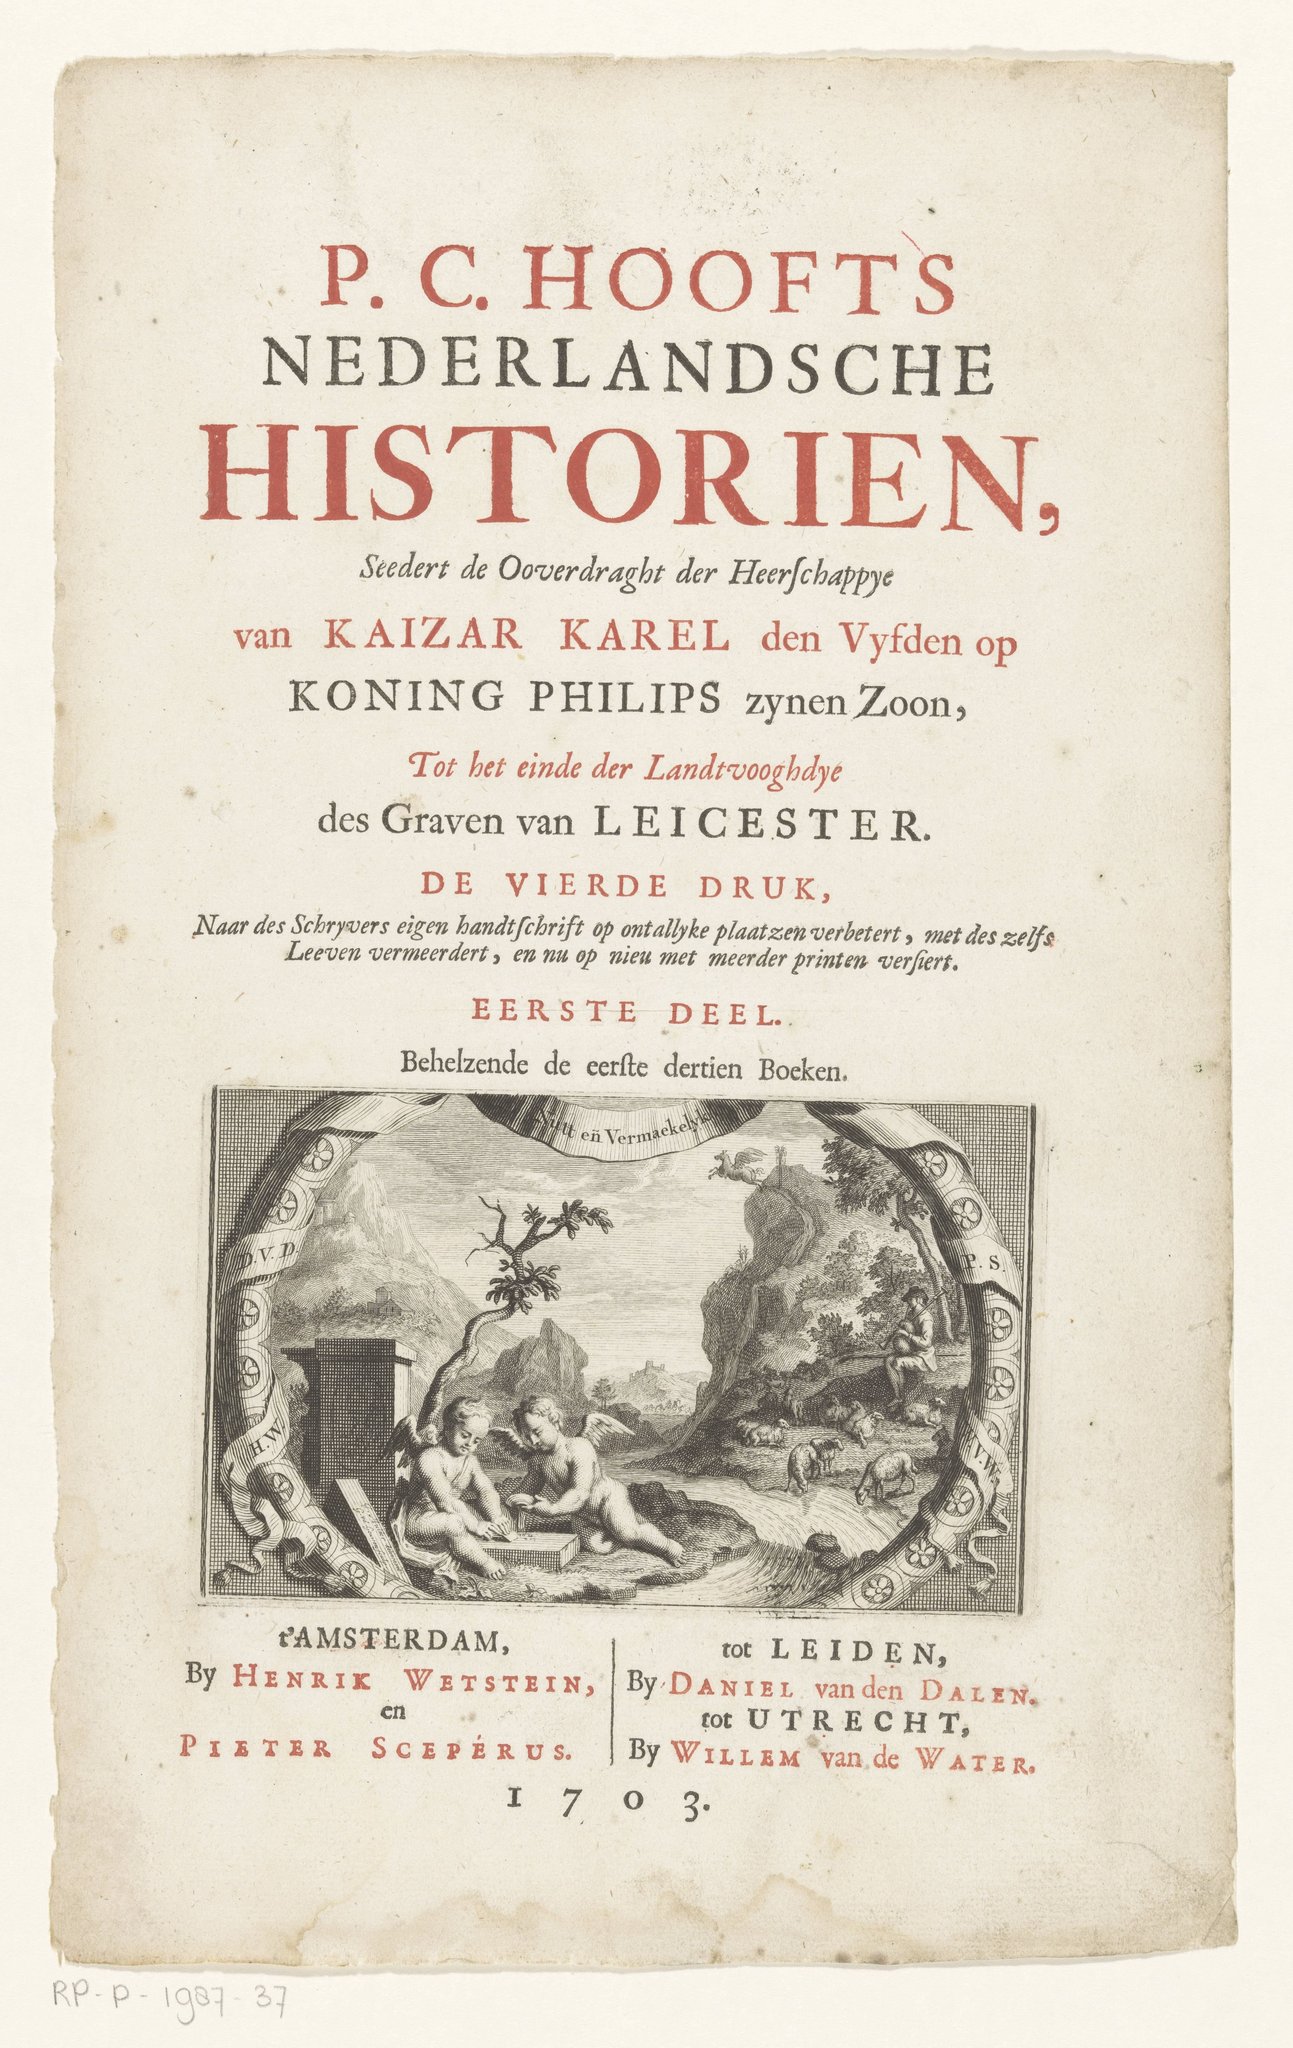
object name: titelblad, titelpagina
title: Titelpagina voor: P.C. Hooft, Nederlandsche historien, 1703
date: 1703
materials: paper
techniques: engraving, letterpress printing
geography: amsterdam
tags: landscapes, herding, herdsman, herdswoman, shepherd, shepherdess, cowherd, etc., bagpipe, musette, cupids: 'amores', 'amoretti', 'putti'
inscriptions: collector's mark: Lugt 2228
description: Titelpagina voor: Hooft, Pieter Corneliszoon. Nederlandsche historien. Amsterdam: Wetstein, Henricus en Scepérus, Pieter; Leiden: Dalen, Daniel van den en Water, Willem van de, 1703.